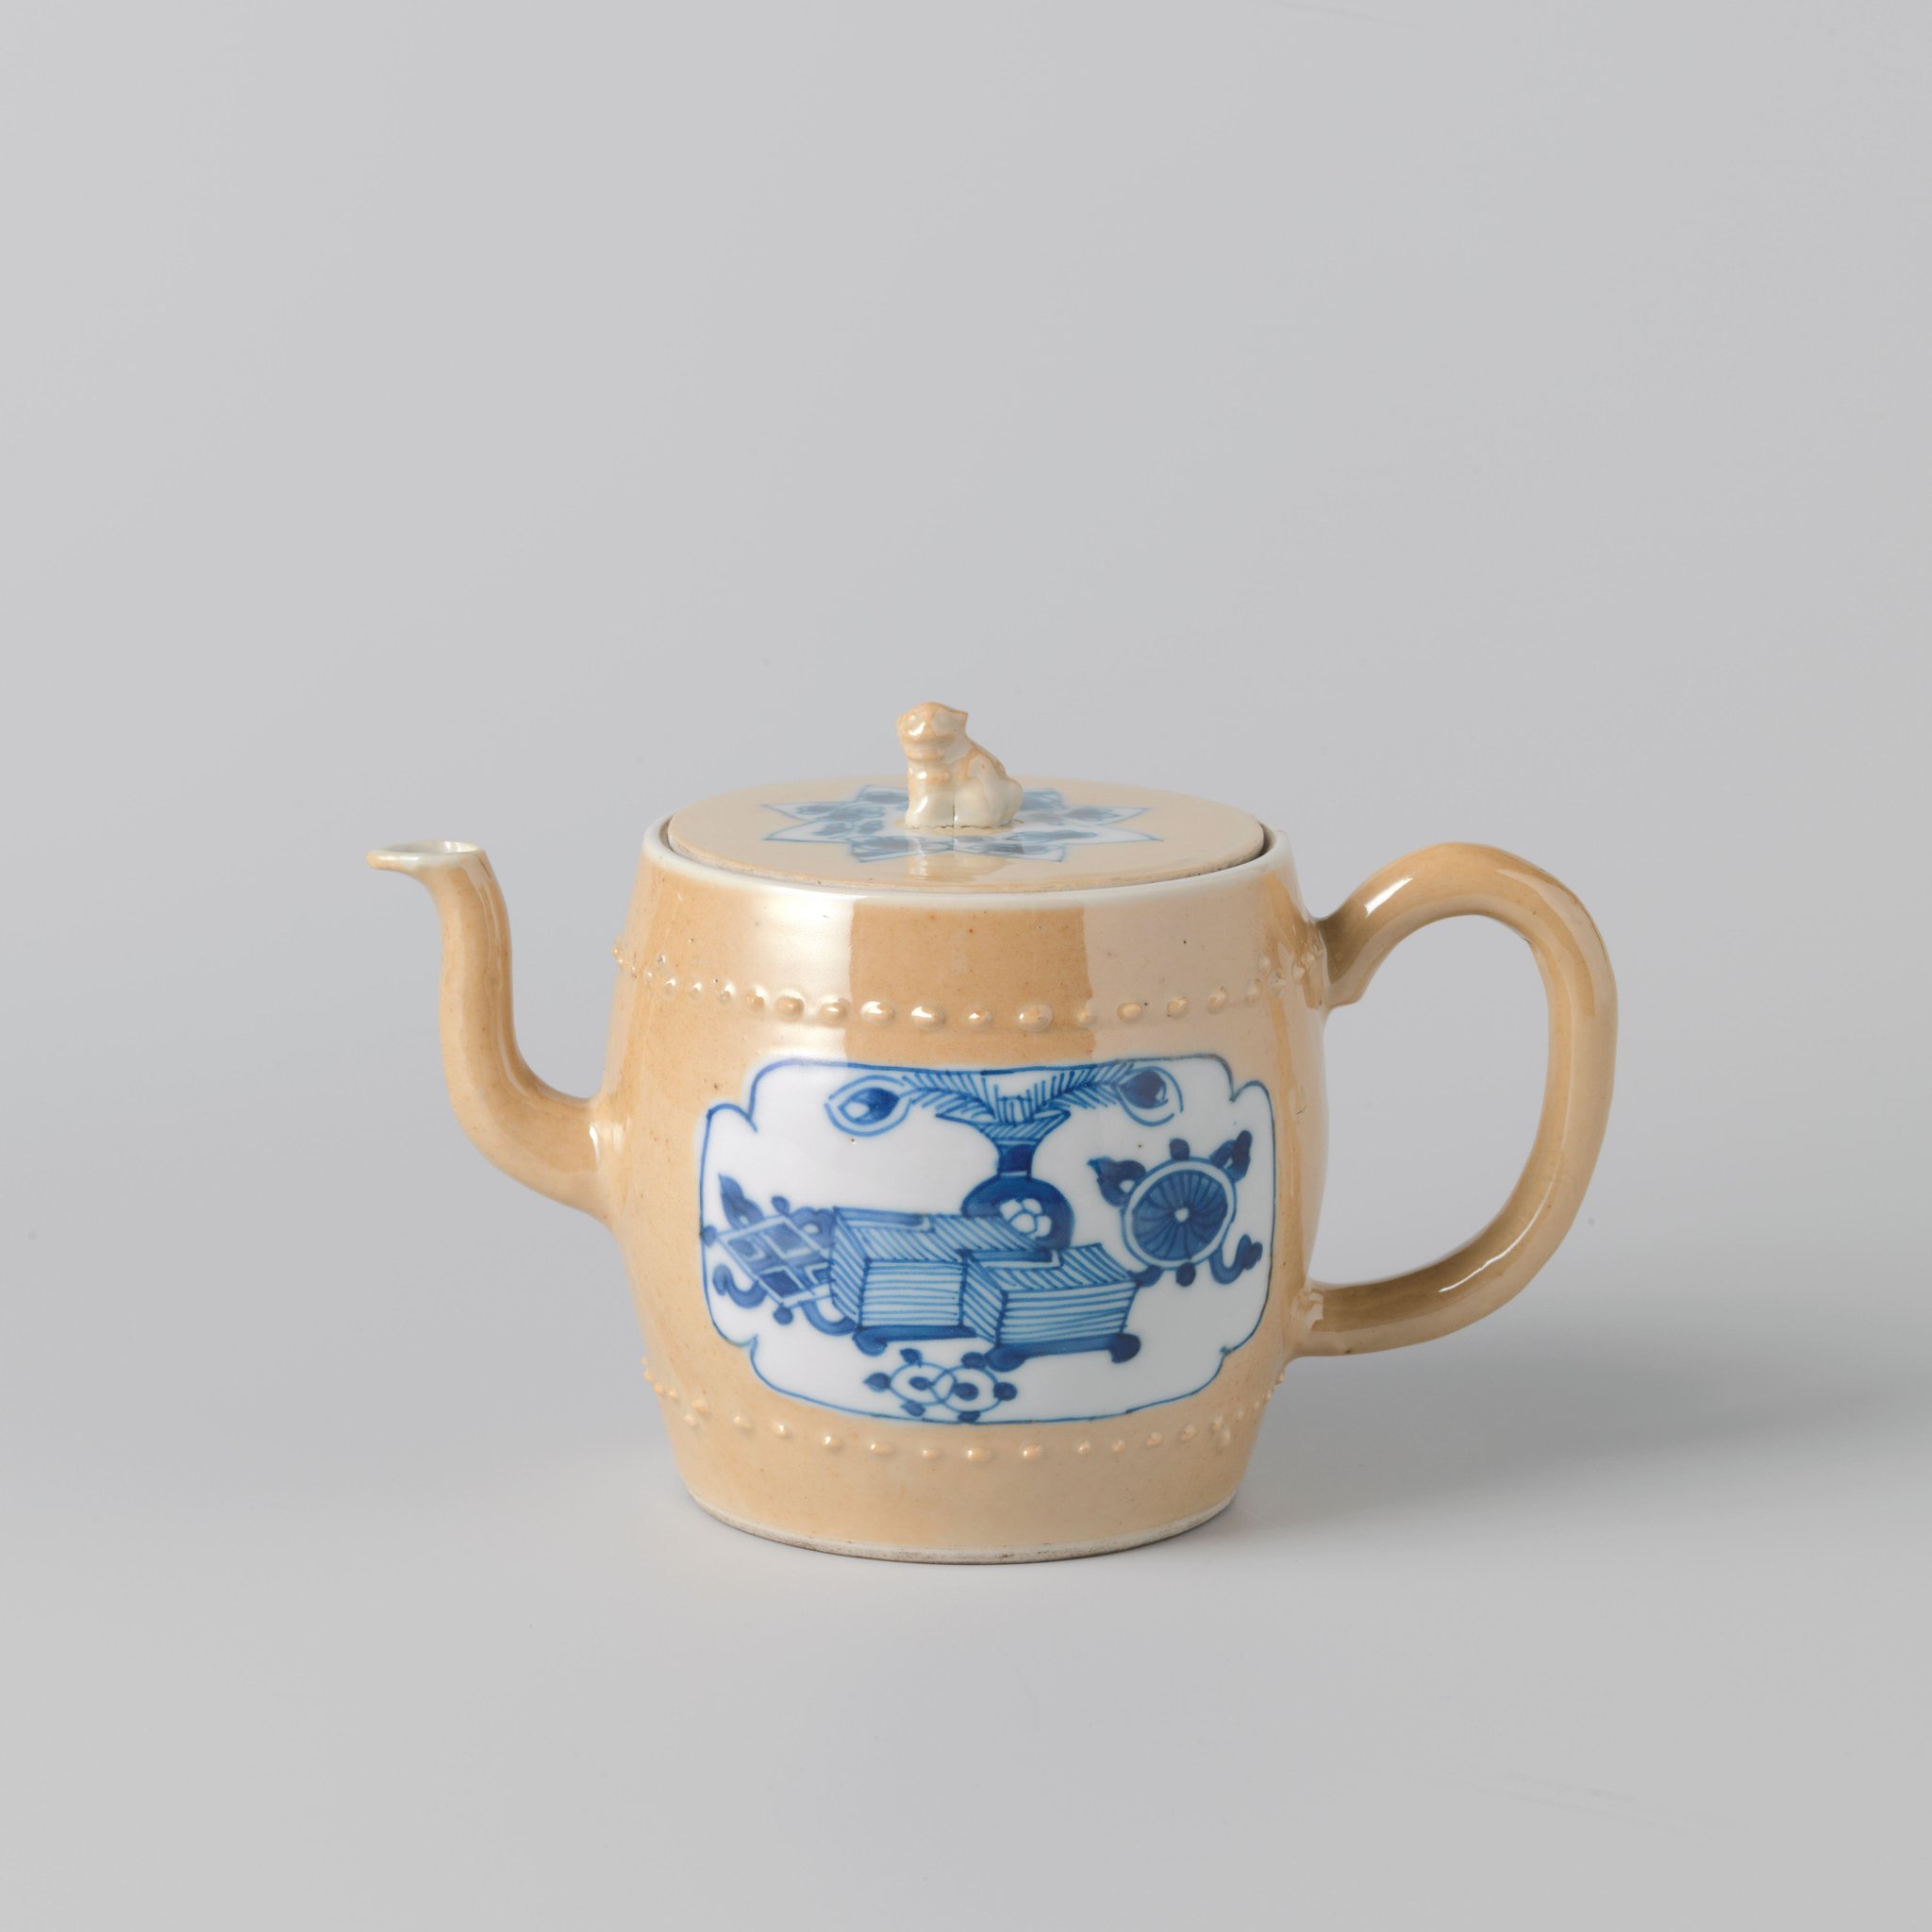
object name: lid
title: Teapot with light brown, flowering plants and antiquities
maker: Anonymous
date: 1700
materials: cobalt, glaze, paint, porcelain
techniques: turning, vitrification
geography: china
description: De deksel met een stervormig cartouche met bloemtakken; dekselknop in de vorm van een shishi (leeuwhond). Monochroom bruin met blauw-wit.